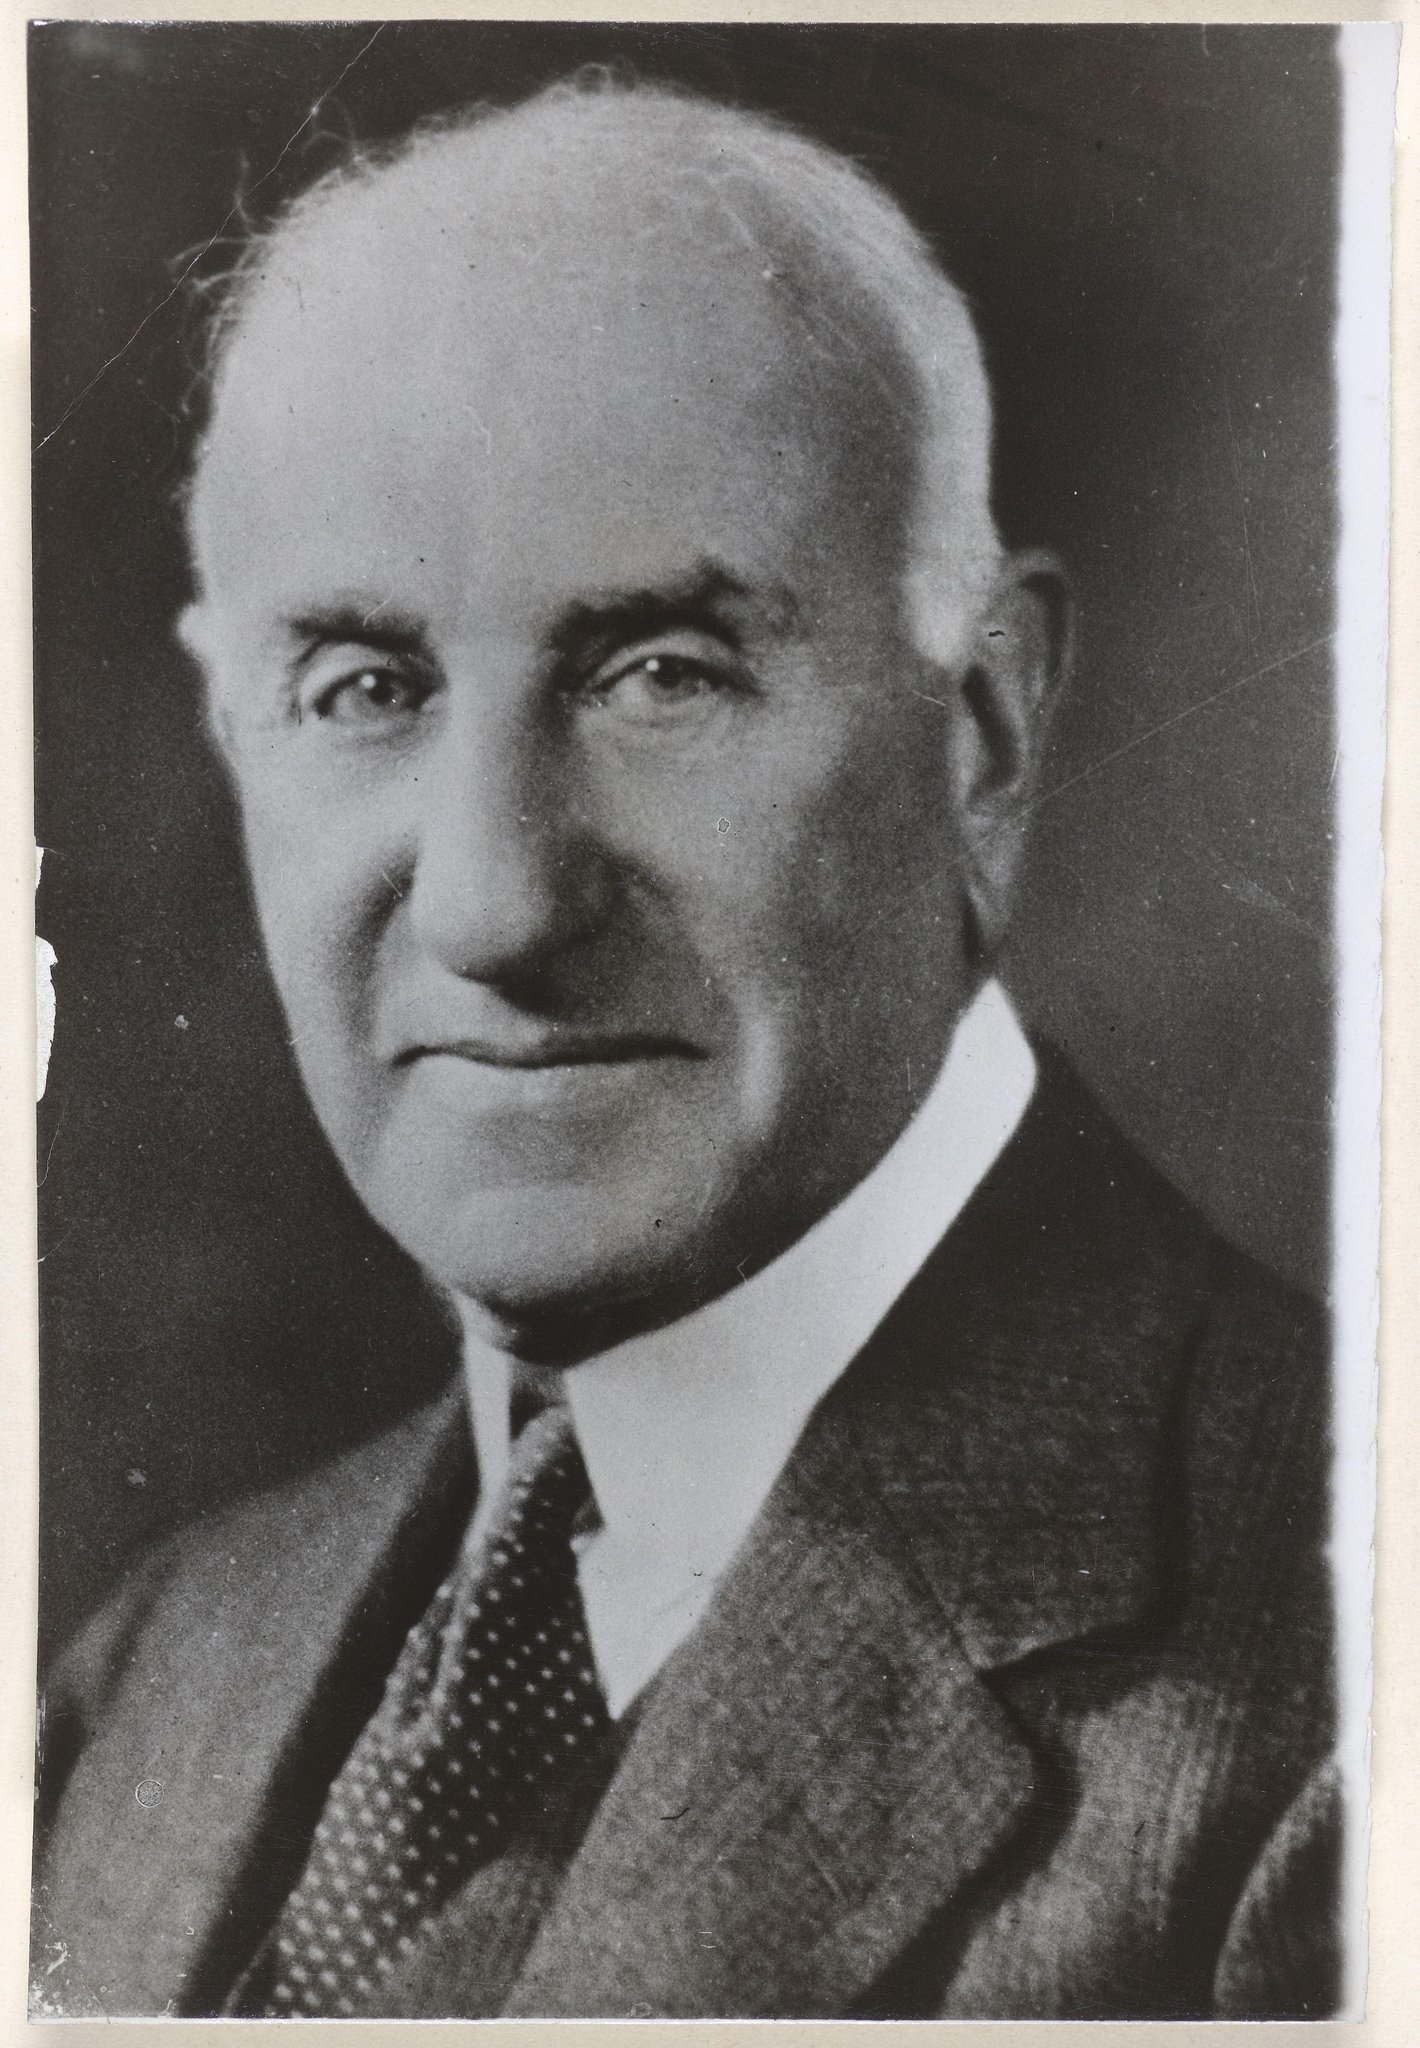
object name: photograph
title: Portret van Solomon Guggenheim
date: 1949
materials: photographic support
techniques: gelatin silver print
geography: new york city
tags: new york (city)